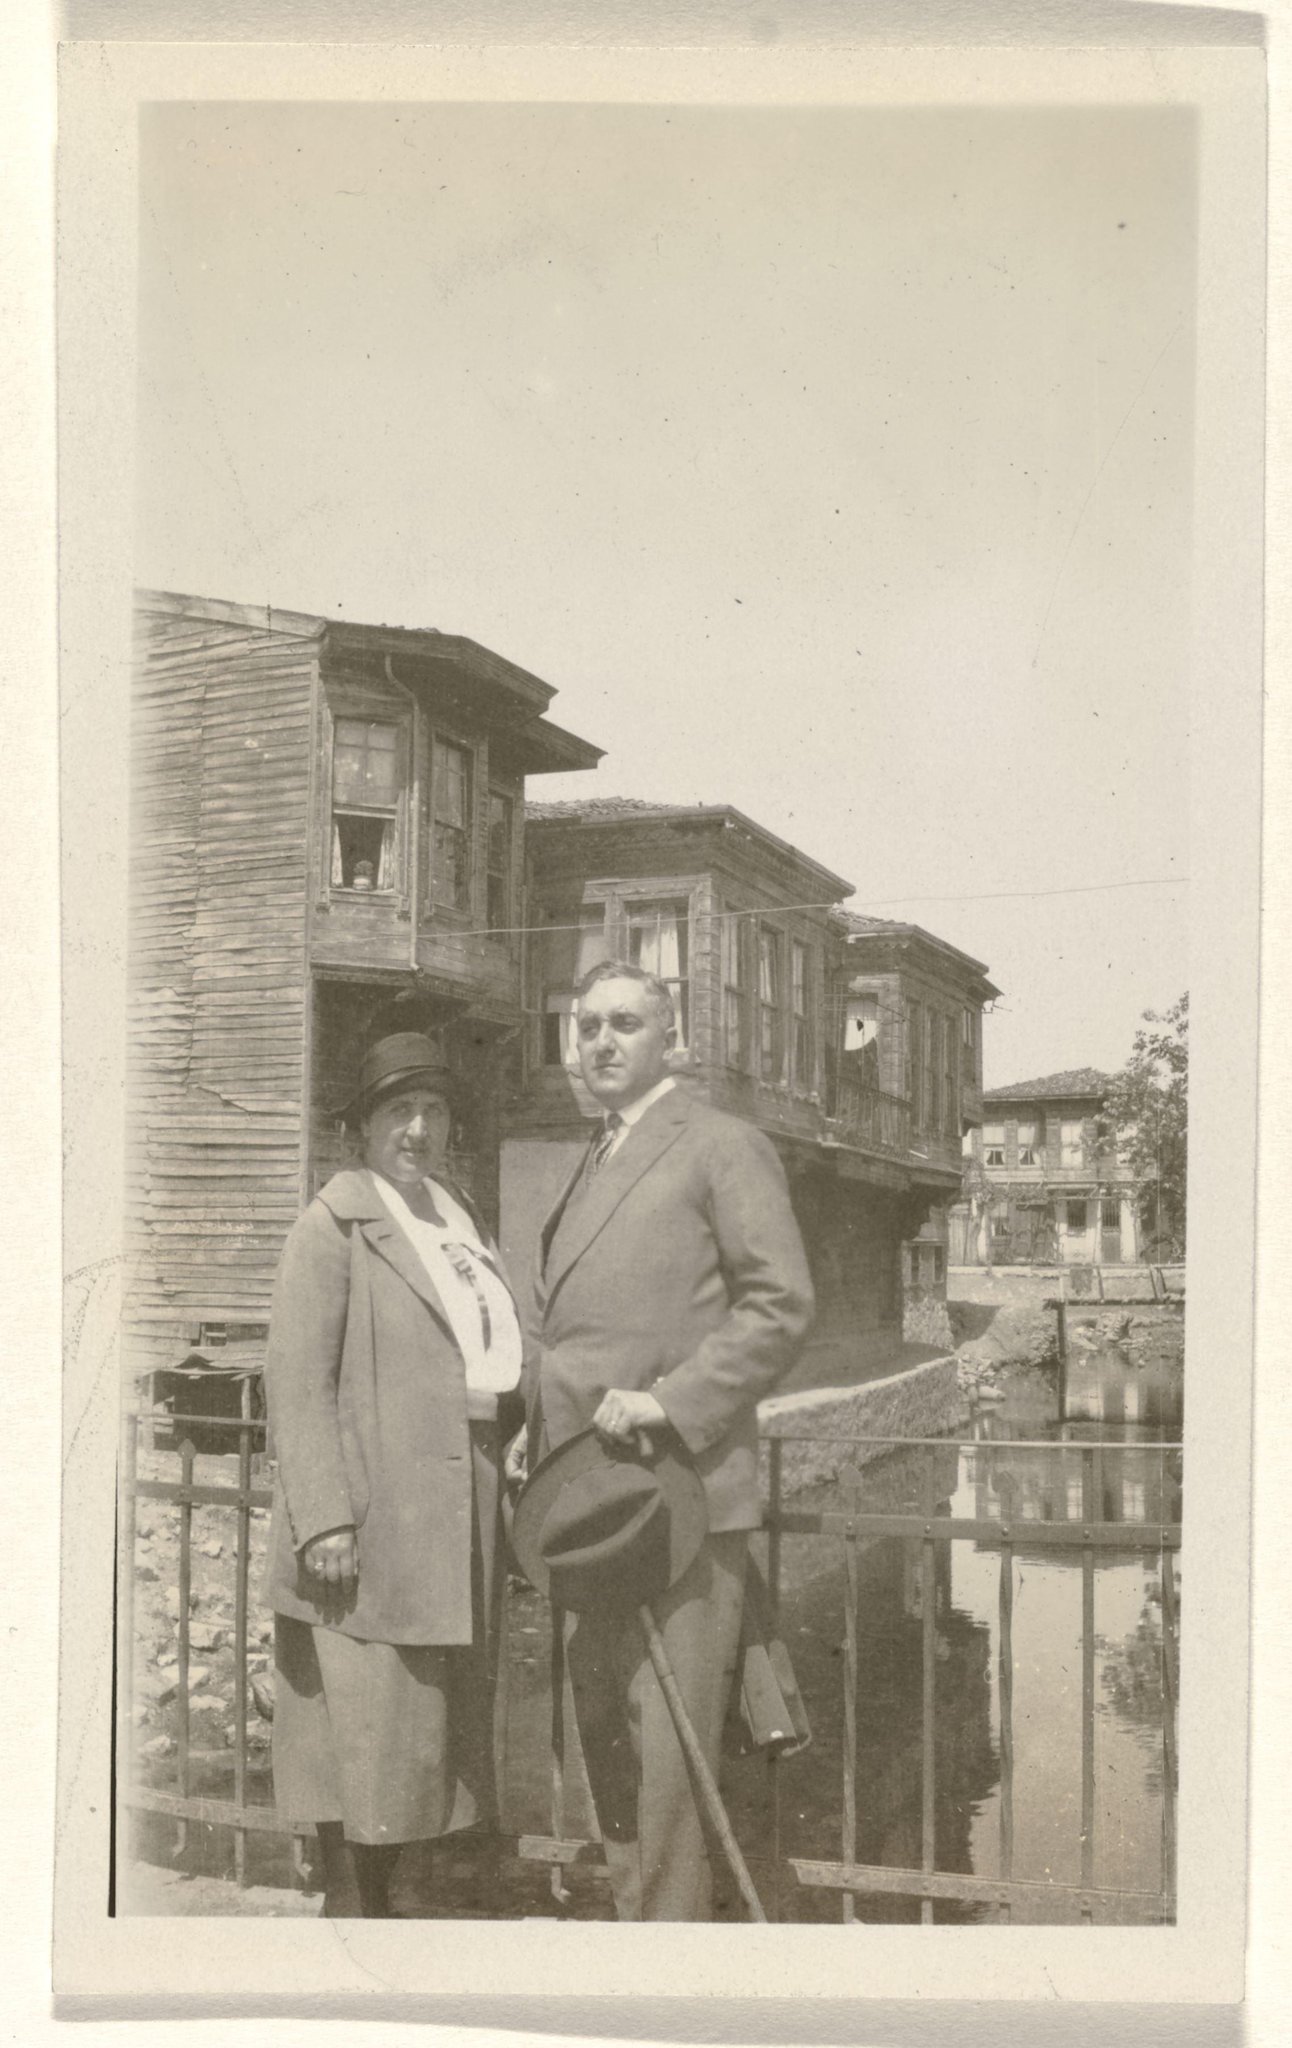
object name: photograph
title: Eugen Wachenheimer met hoed en wandelstok in de hand en zijn echtgenote Else Wachenheimer-Moos, staand voor woningen die boven water zijn gebouwd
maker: Anonymous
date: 1922-1937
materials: photographic support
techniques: gelatin silver print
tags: eugen wachenheimer, else wachenheimer-moos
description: Eugen Wachenheimer met hoed en wandelstok in de hand en zijn echtgenote Else Wachenheimer-Moos in lichtdonkere jas en licht hemd, staand voor woningen die boven water zijn gebouwd.